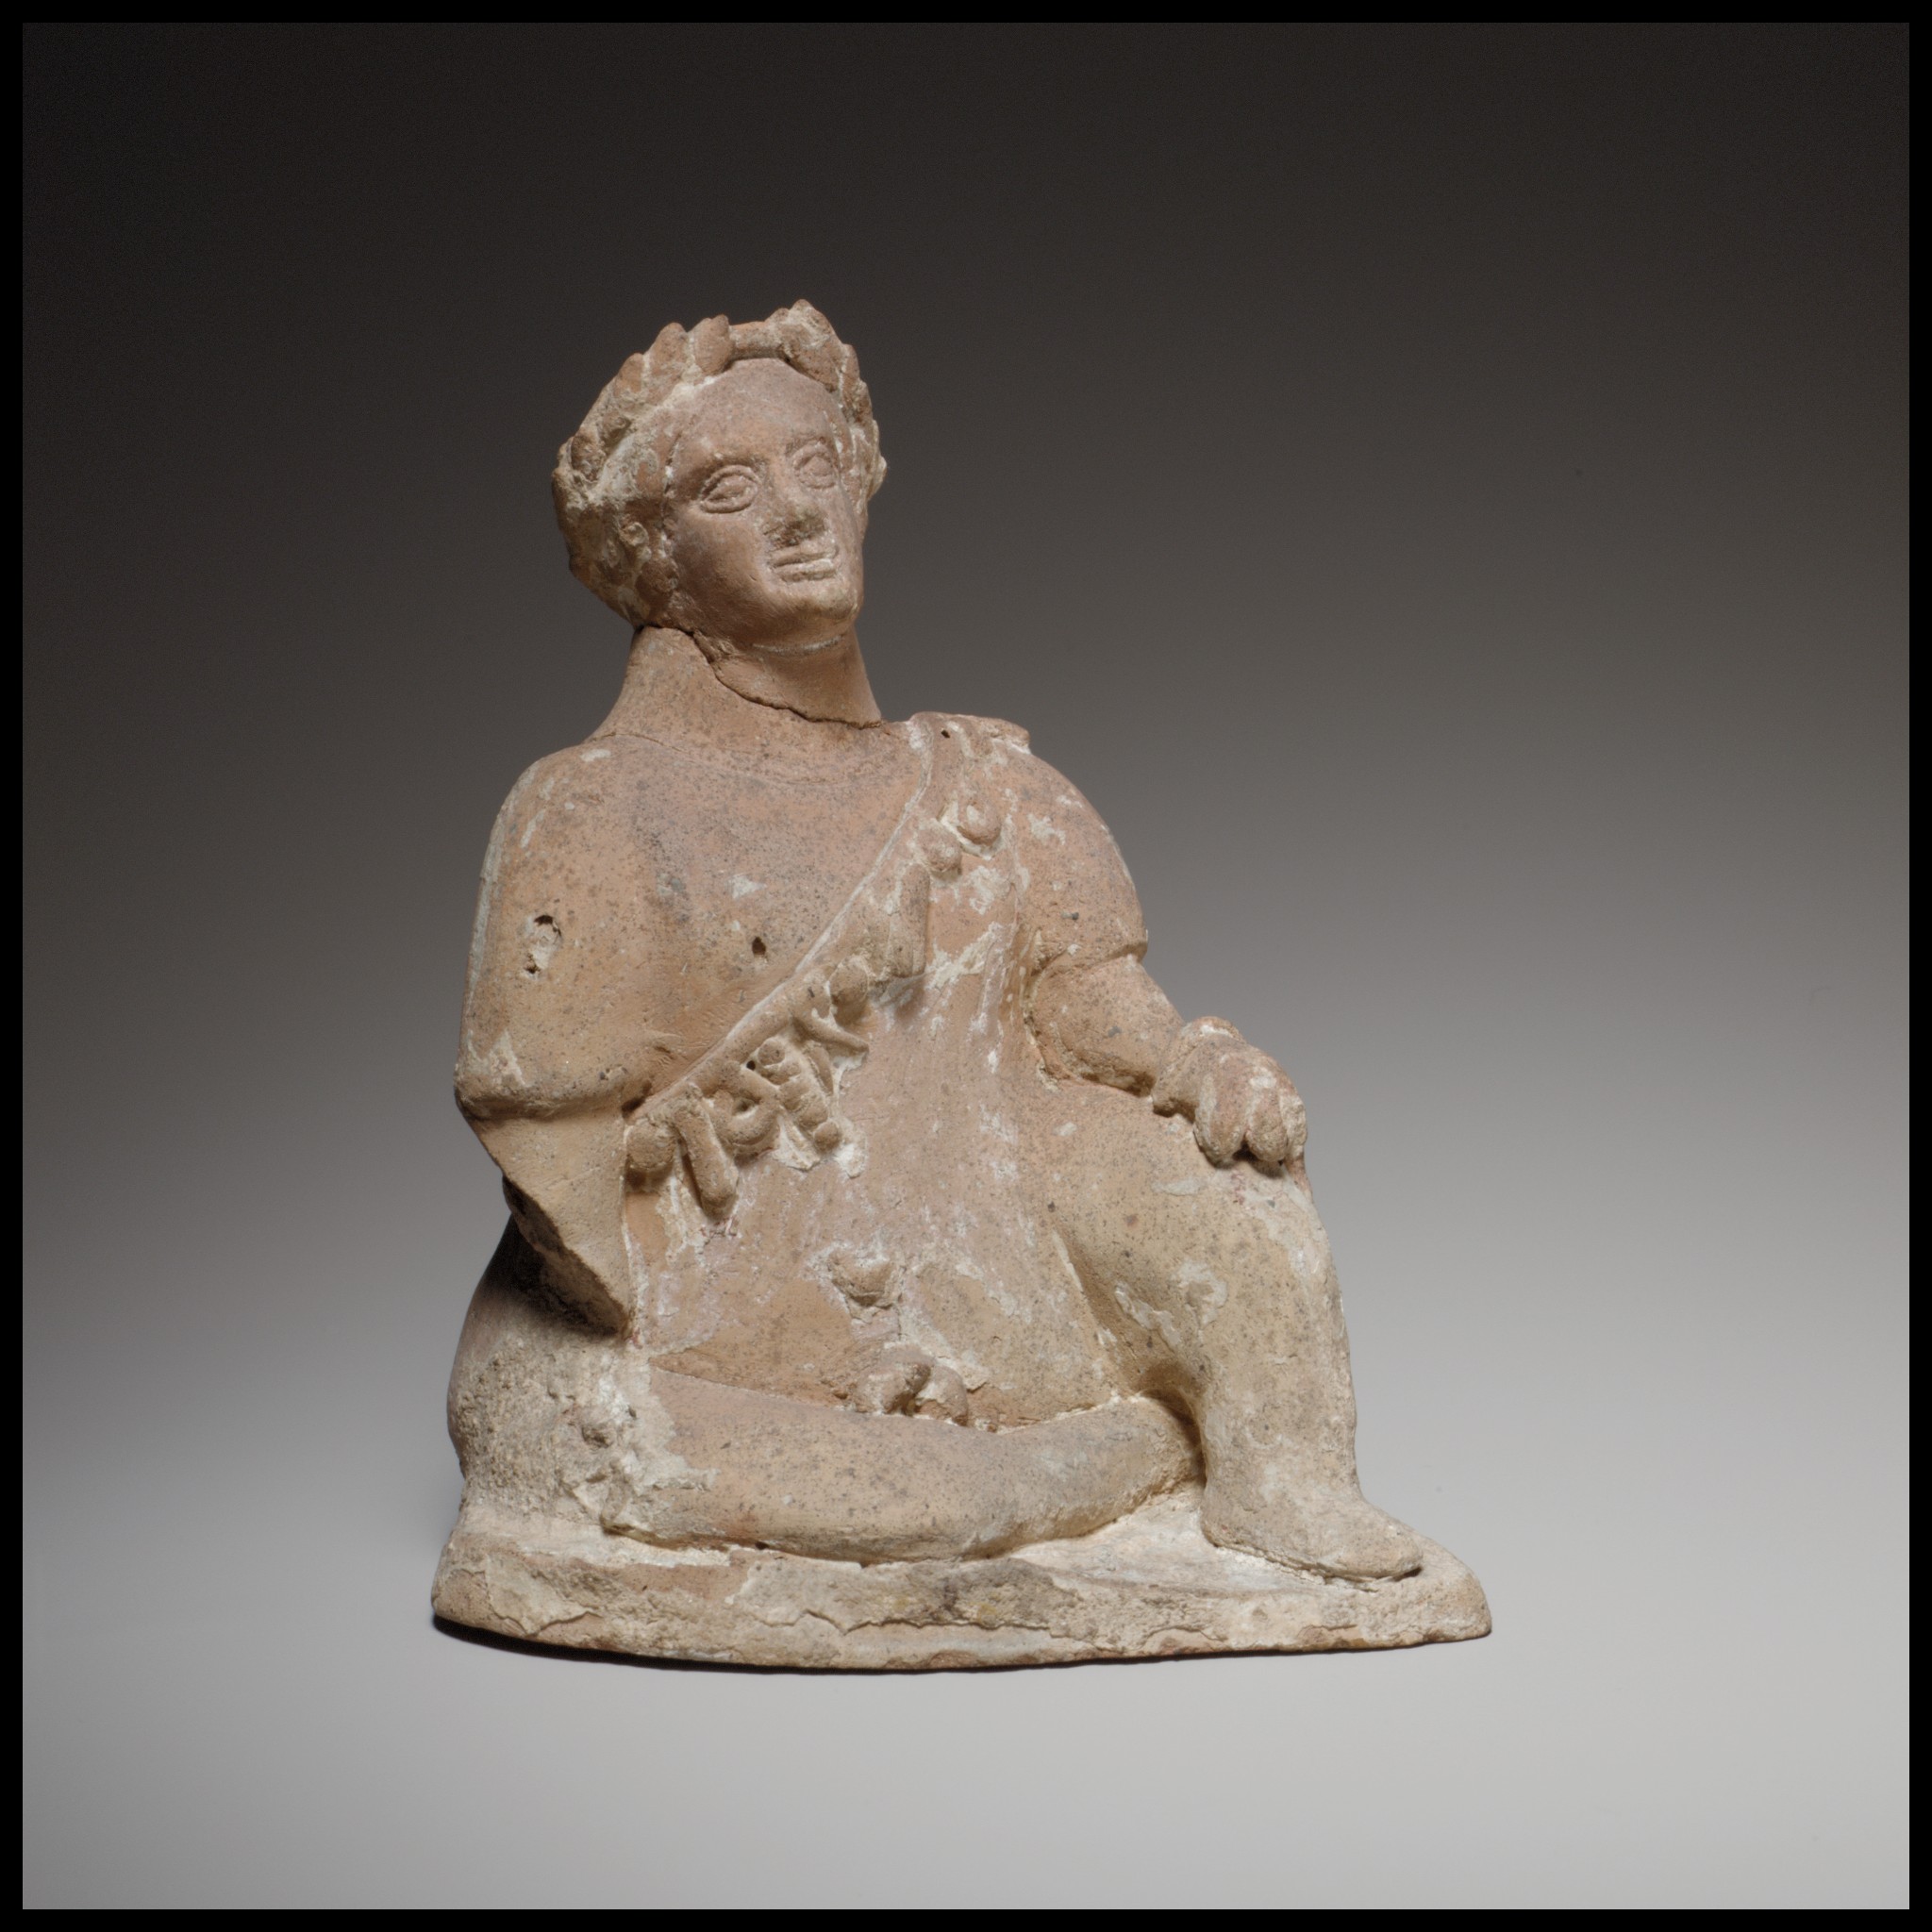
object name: statuette of a temple boy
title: Seated boy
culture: cypriot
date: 400-301 BCE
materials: terracotta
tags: boys